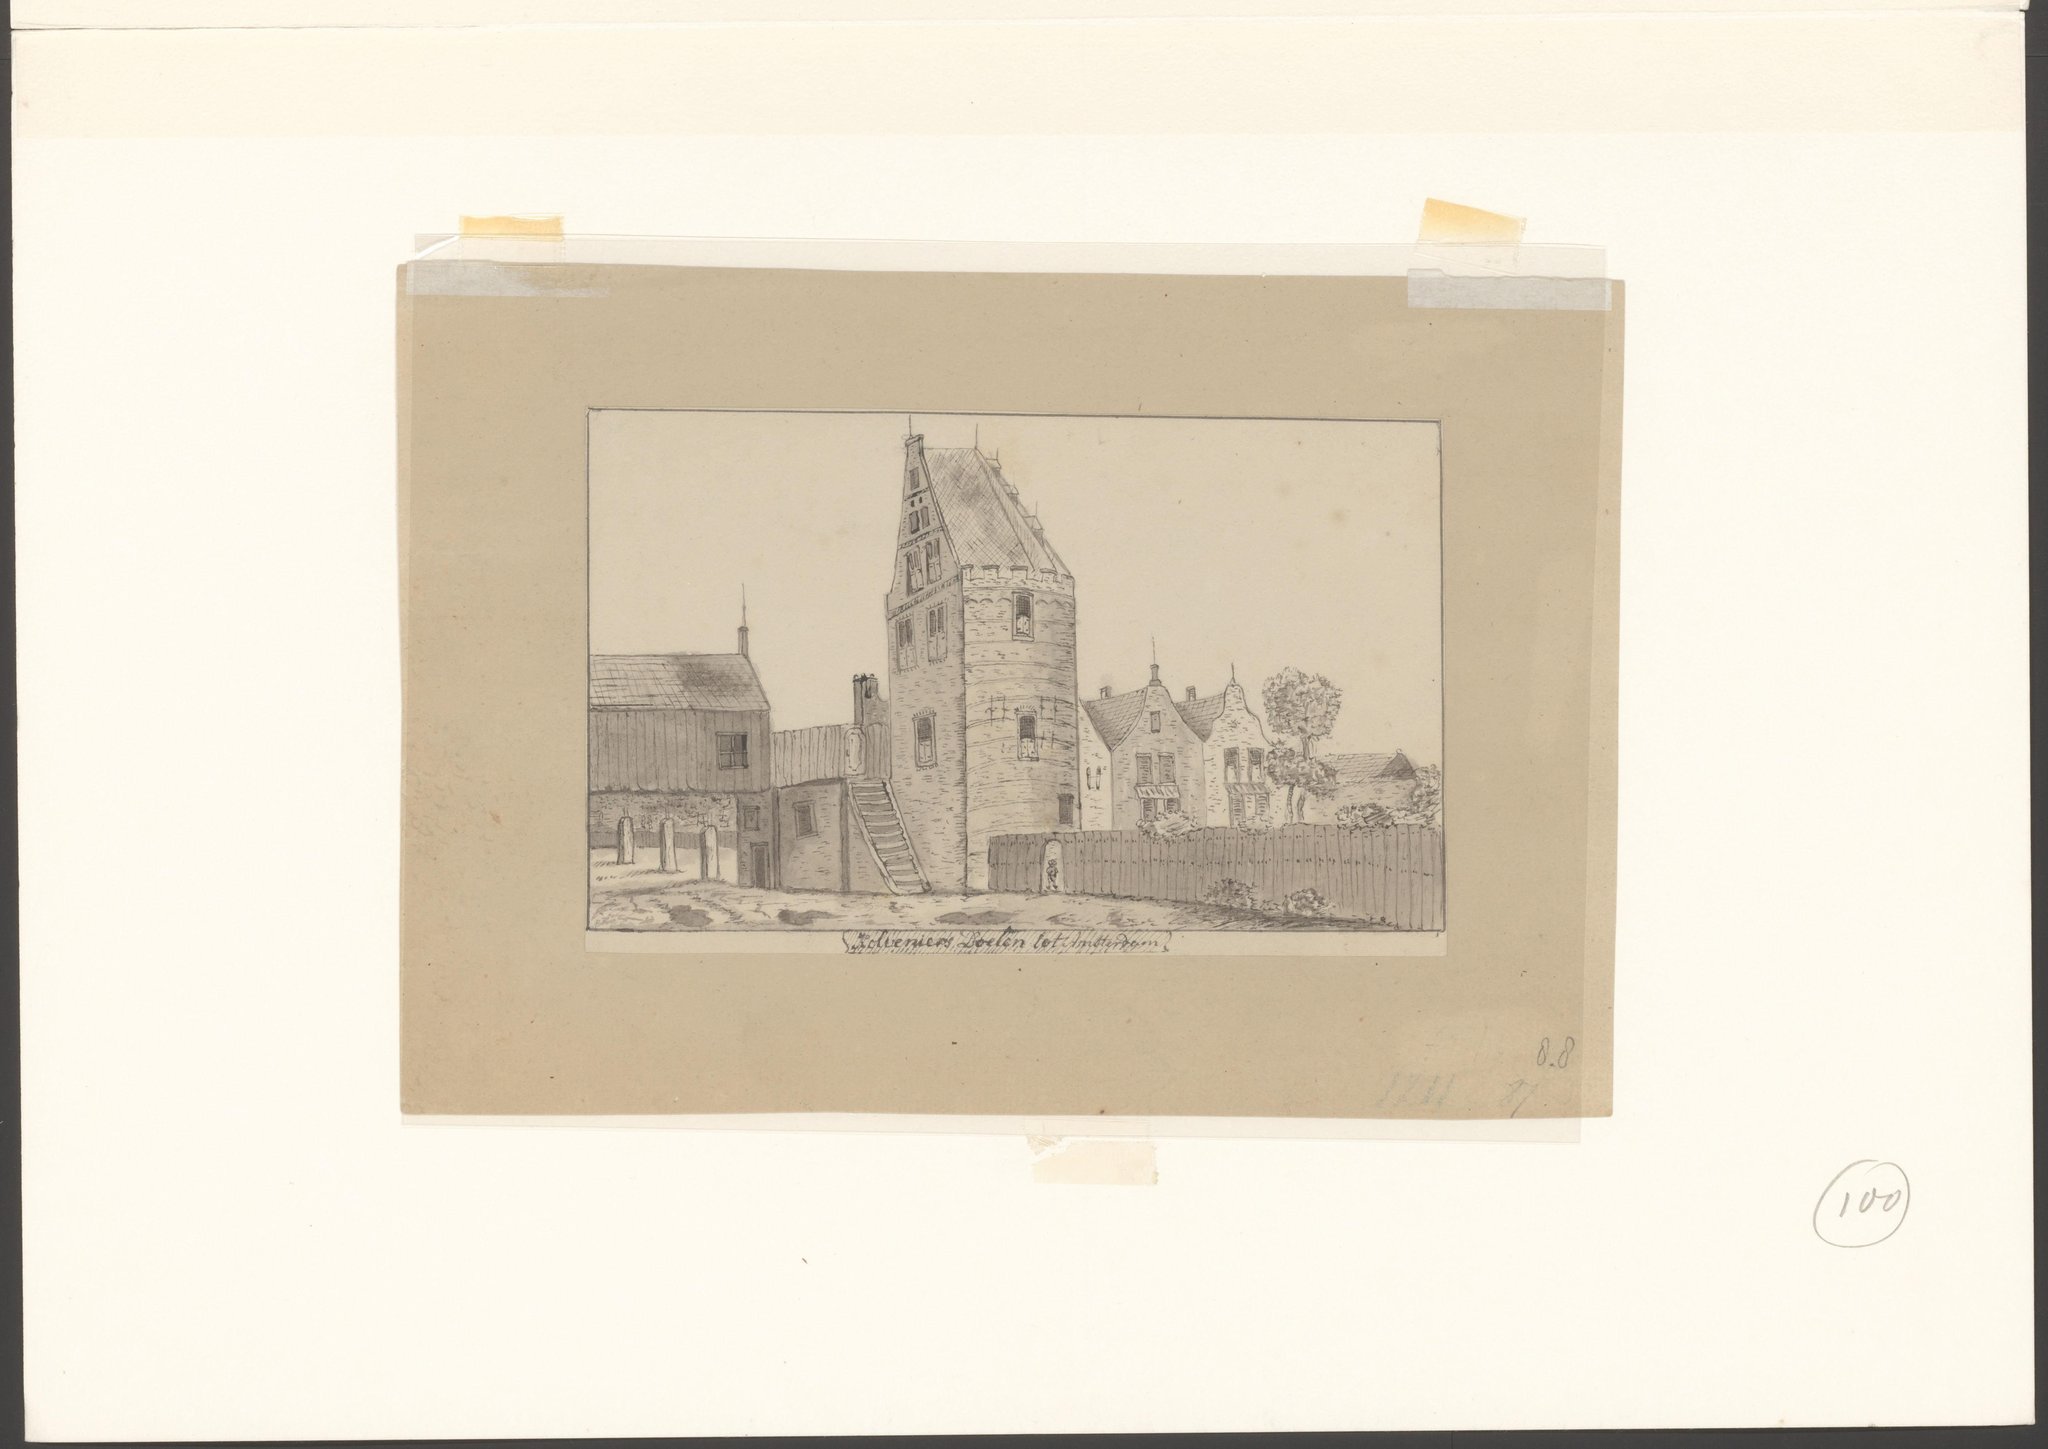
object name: drawing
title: Gezicht op de Kloveniersdoelen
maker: Anonymous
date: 1750-1799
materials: ink, paper, pencil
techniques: brush, pen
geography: amsterdam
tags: artillery range, firing range, shooting range ~ military training, city-view in general; 'veduta'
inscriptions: inscription: ‘Kloveniers Doelen te Amsterdam’, inscription: ‘Kolveniers Doelen tot Amsterdam’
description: Onderwerpsrubriek binnen de Atlas Amsterdam: Vestingwerken: Bolwerken - Rondeel - Wachttorens - Blokhuizen - Kazematten - Ontwerpen Kostuum Alva.